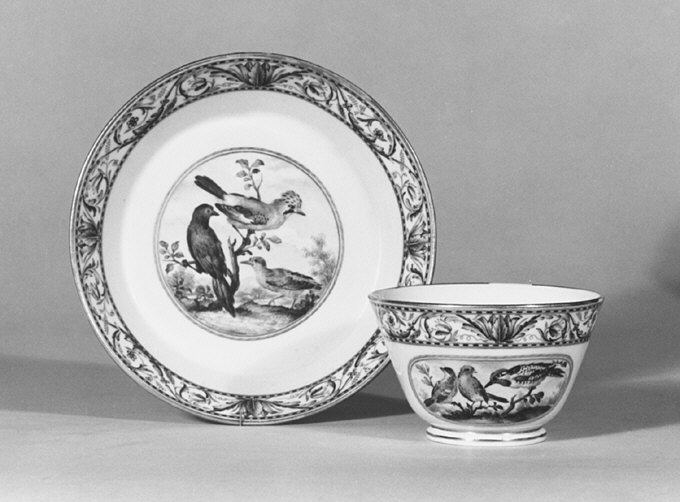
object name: saucer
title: Saucer (part of a service)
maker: meissen manufactory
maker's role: manufactory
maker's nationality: german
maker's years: 1710-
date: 1780-1785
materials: hard paste porcelain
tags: birds,plants